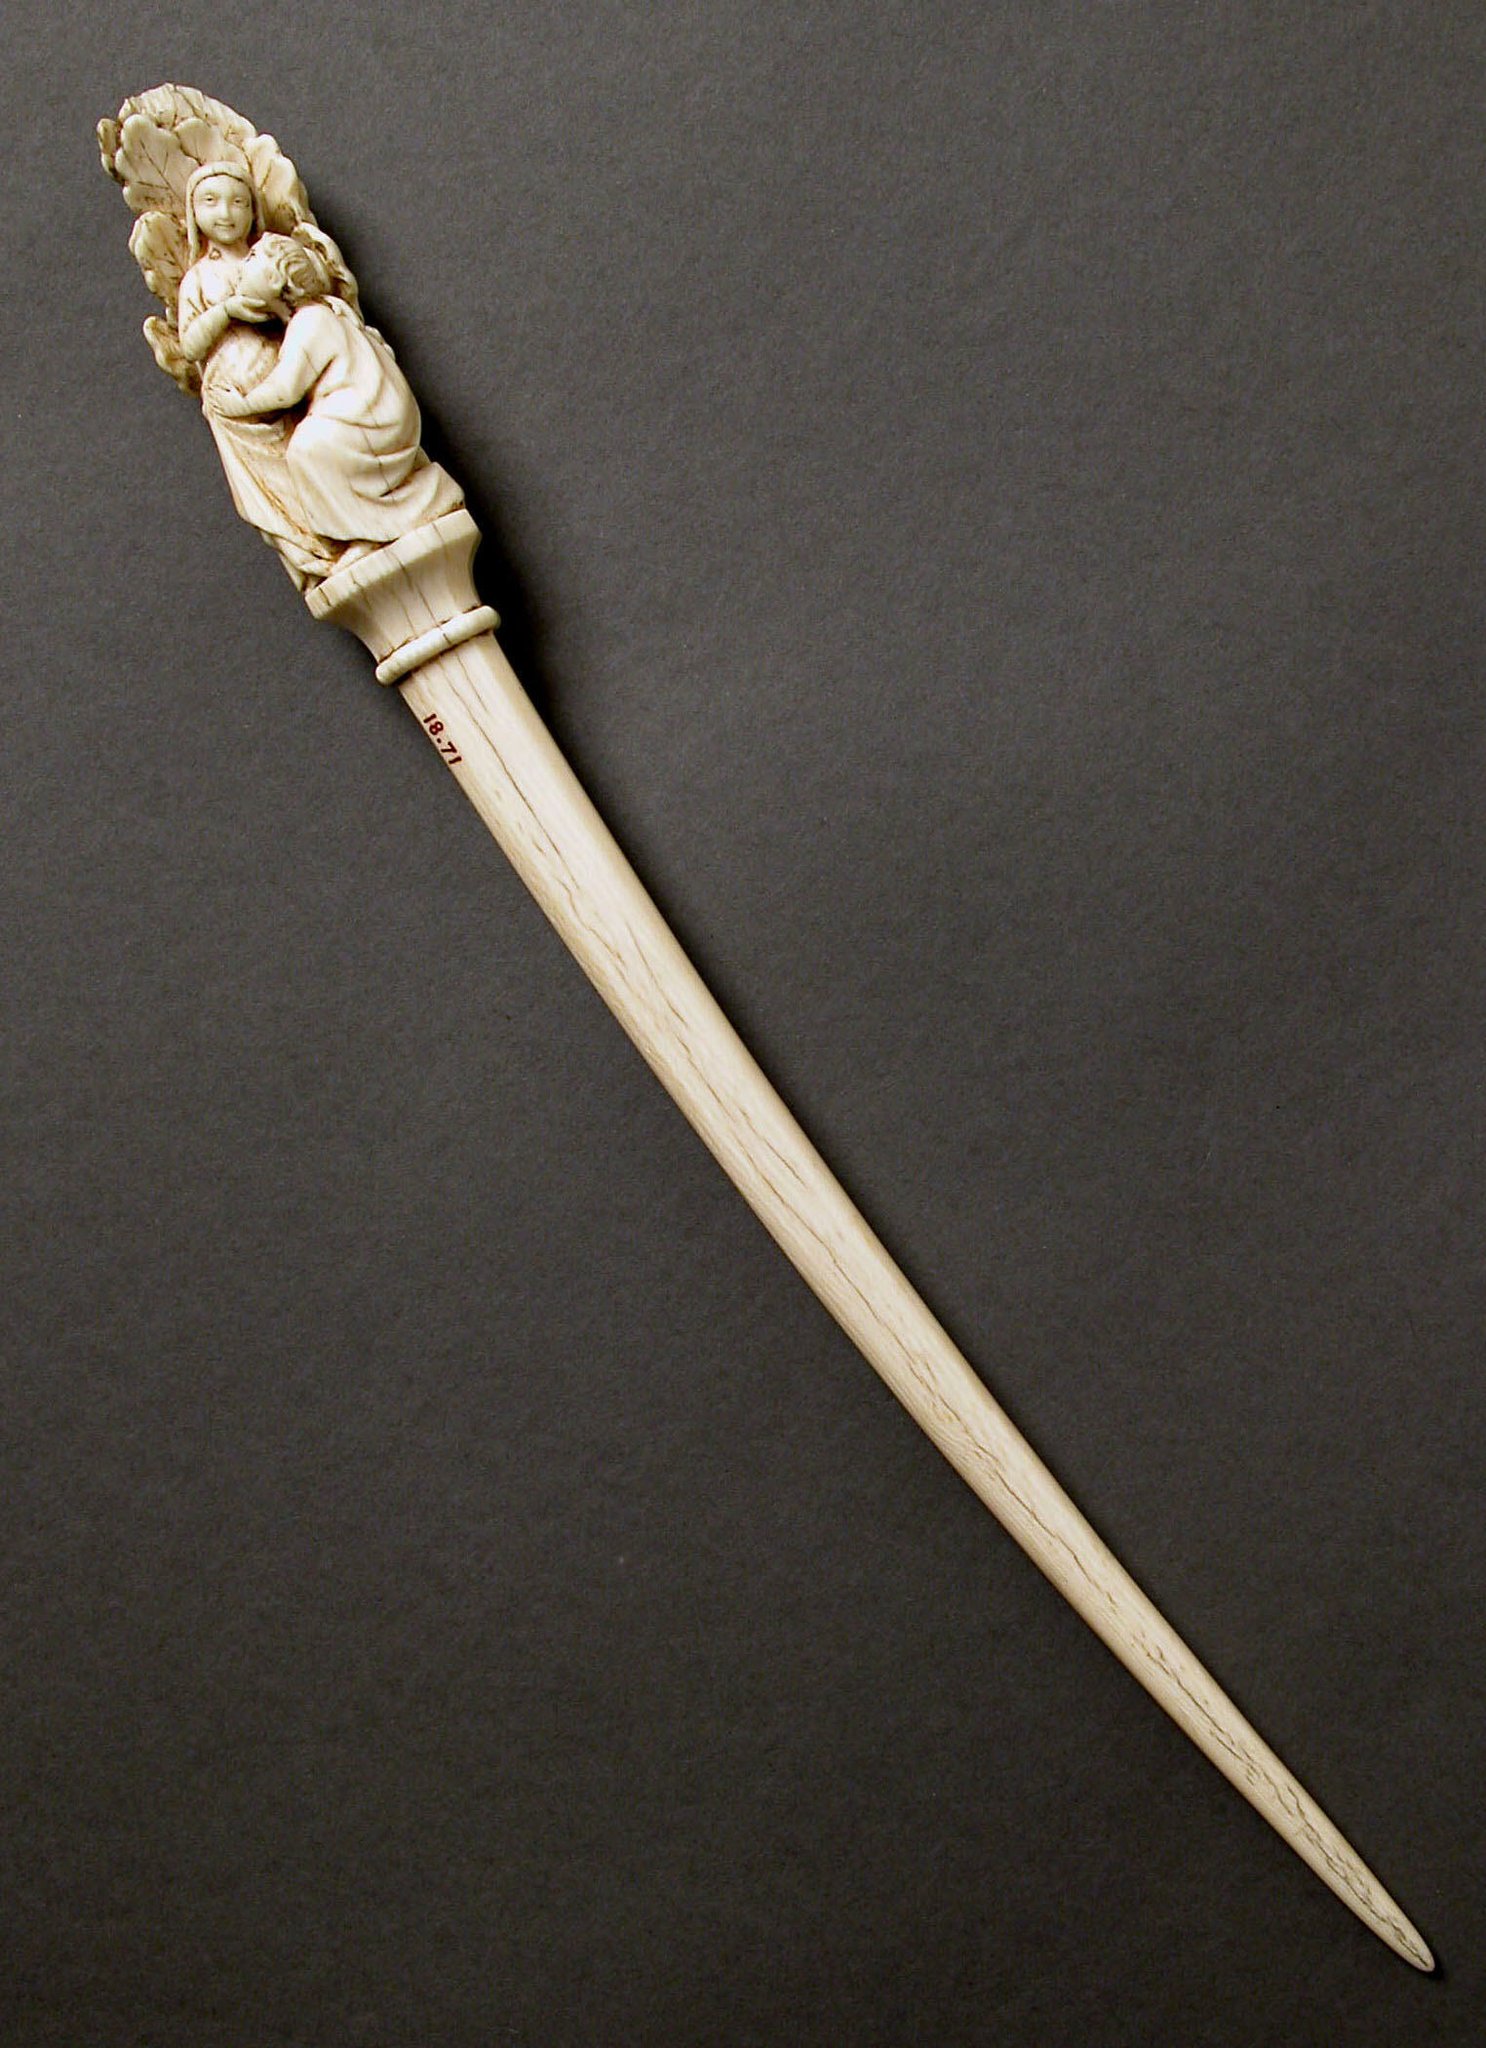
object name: parter, hair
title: Hair Parter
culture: european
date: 1801-1900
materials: ivory